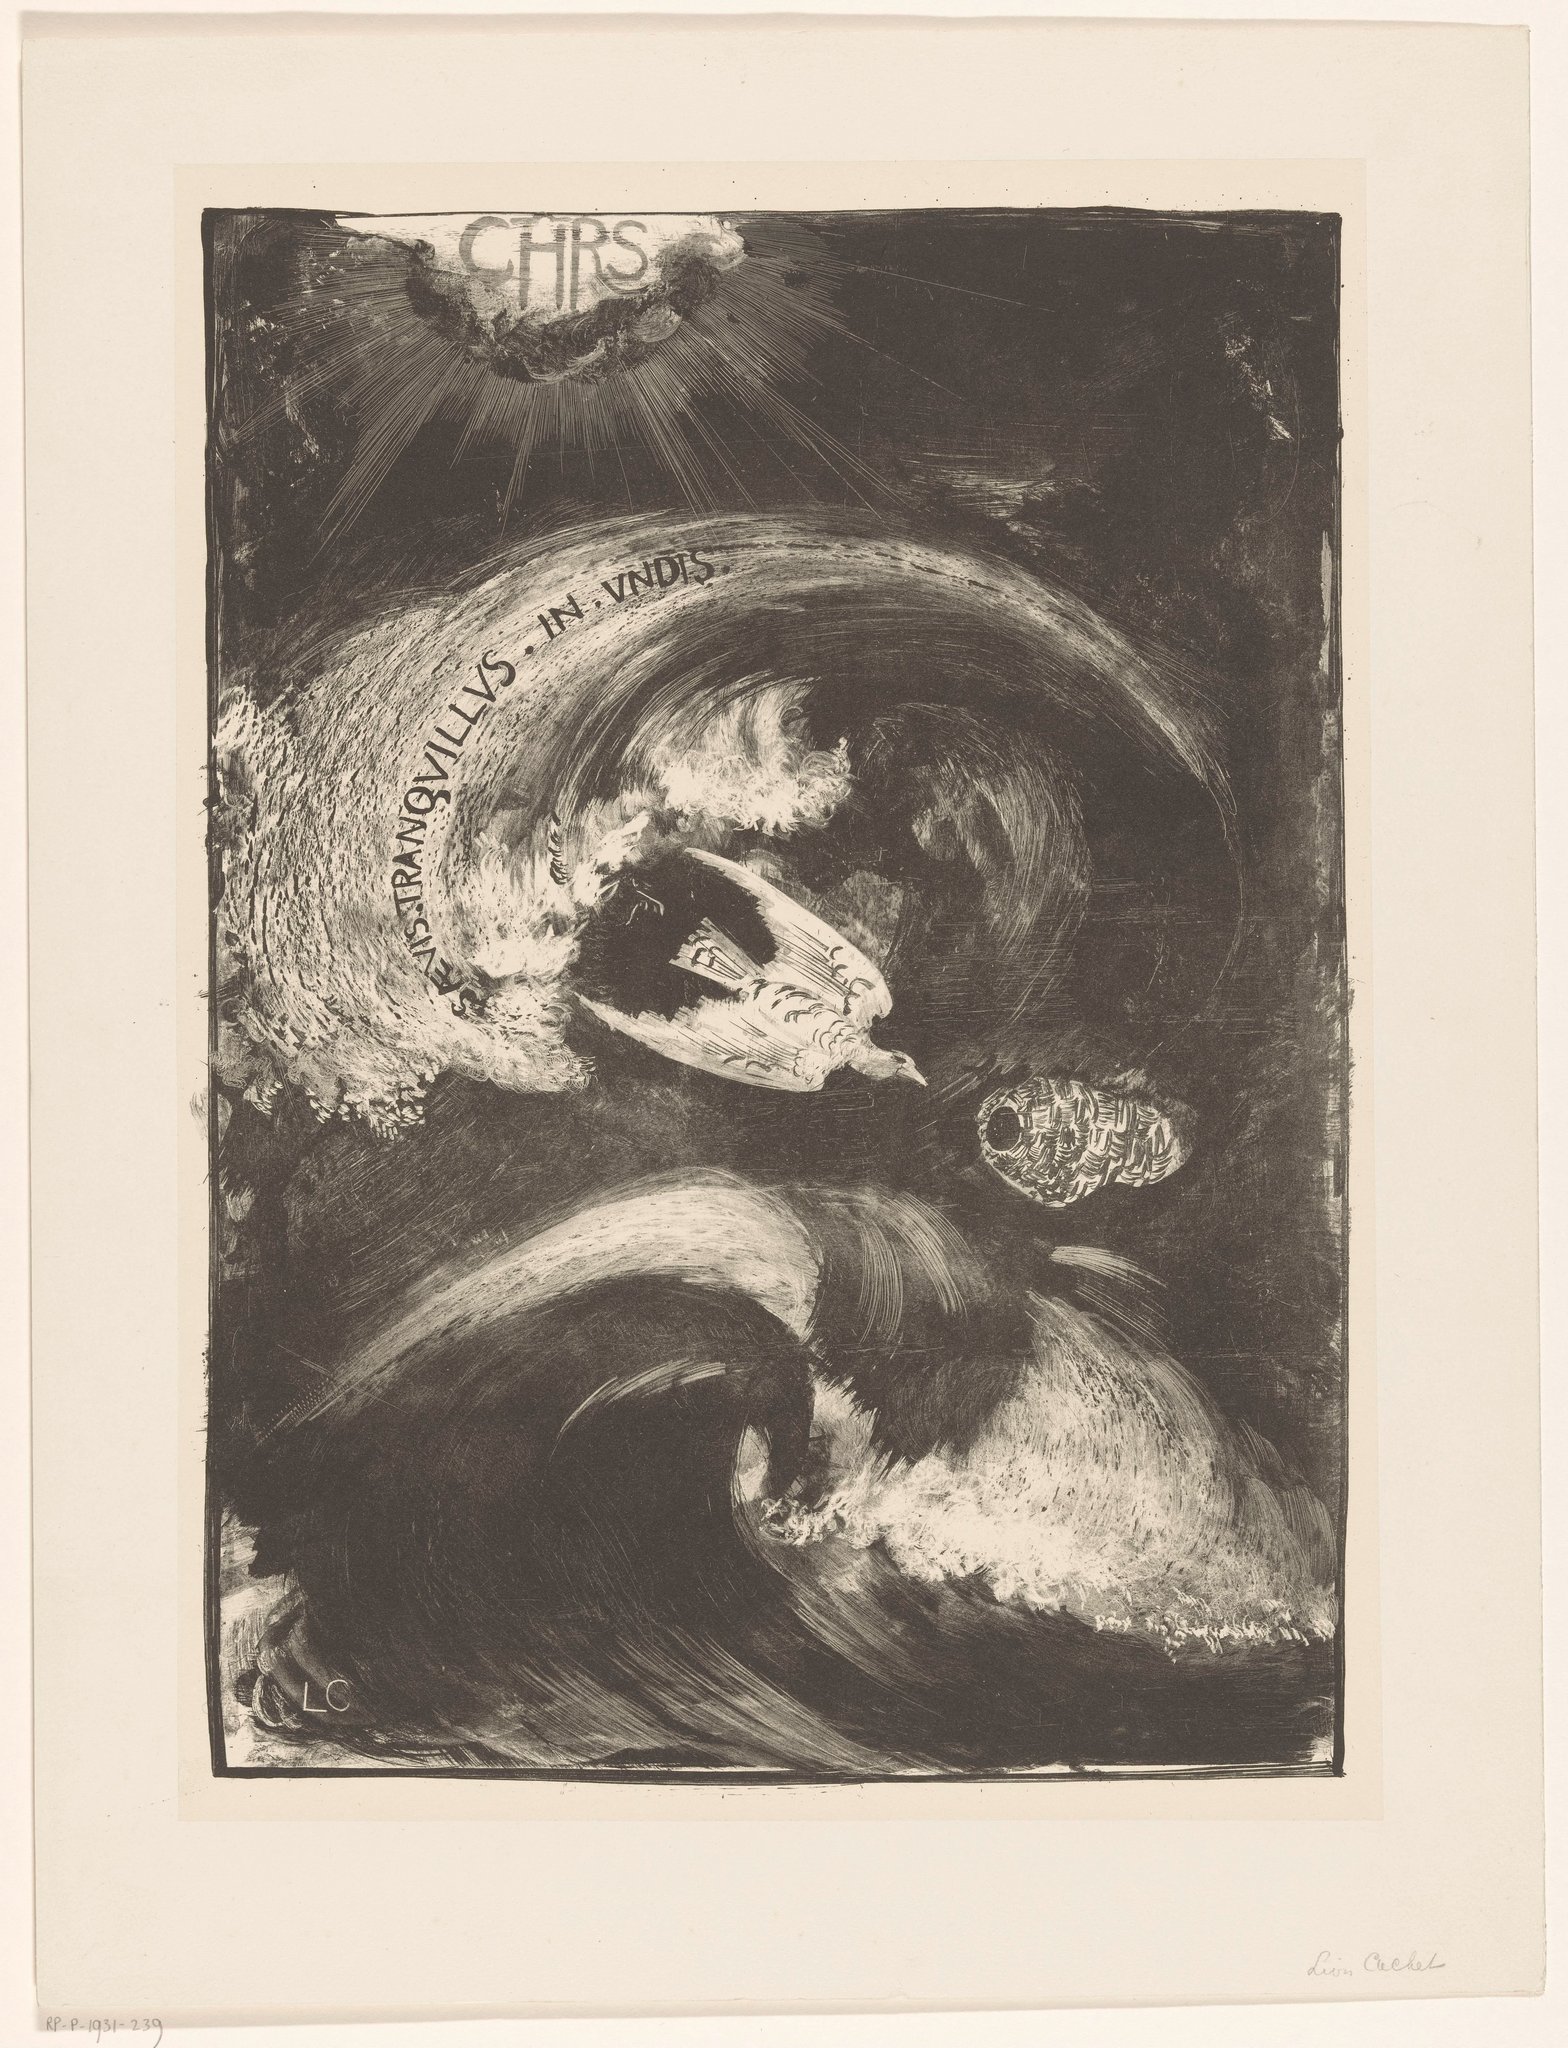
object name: print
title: Duif in storm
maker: carel adolph lion cachet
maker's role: draughtsman, print maker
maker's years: 1864-1945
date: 1874-1931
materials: paper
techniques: lithograph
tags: storm at sea, doves, pigeons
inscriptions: collector's mark: Lugt 2228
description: Een witte duif vliegt boven stormachtige golven. Achter hem de spreuk 'Saevis tranquillus in undis'. Bovenaan een wolk met de letters CHRS.